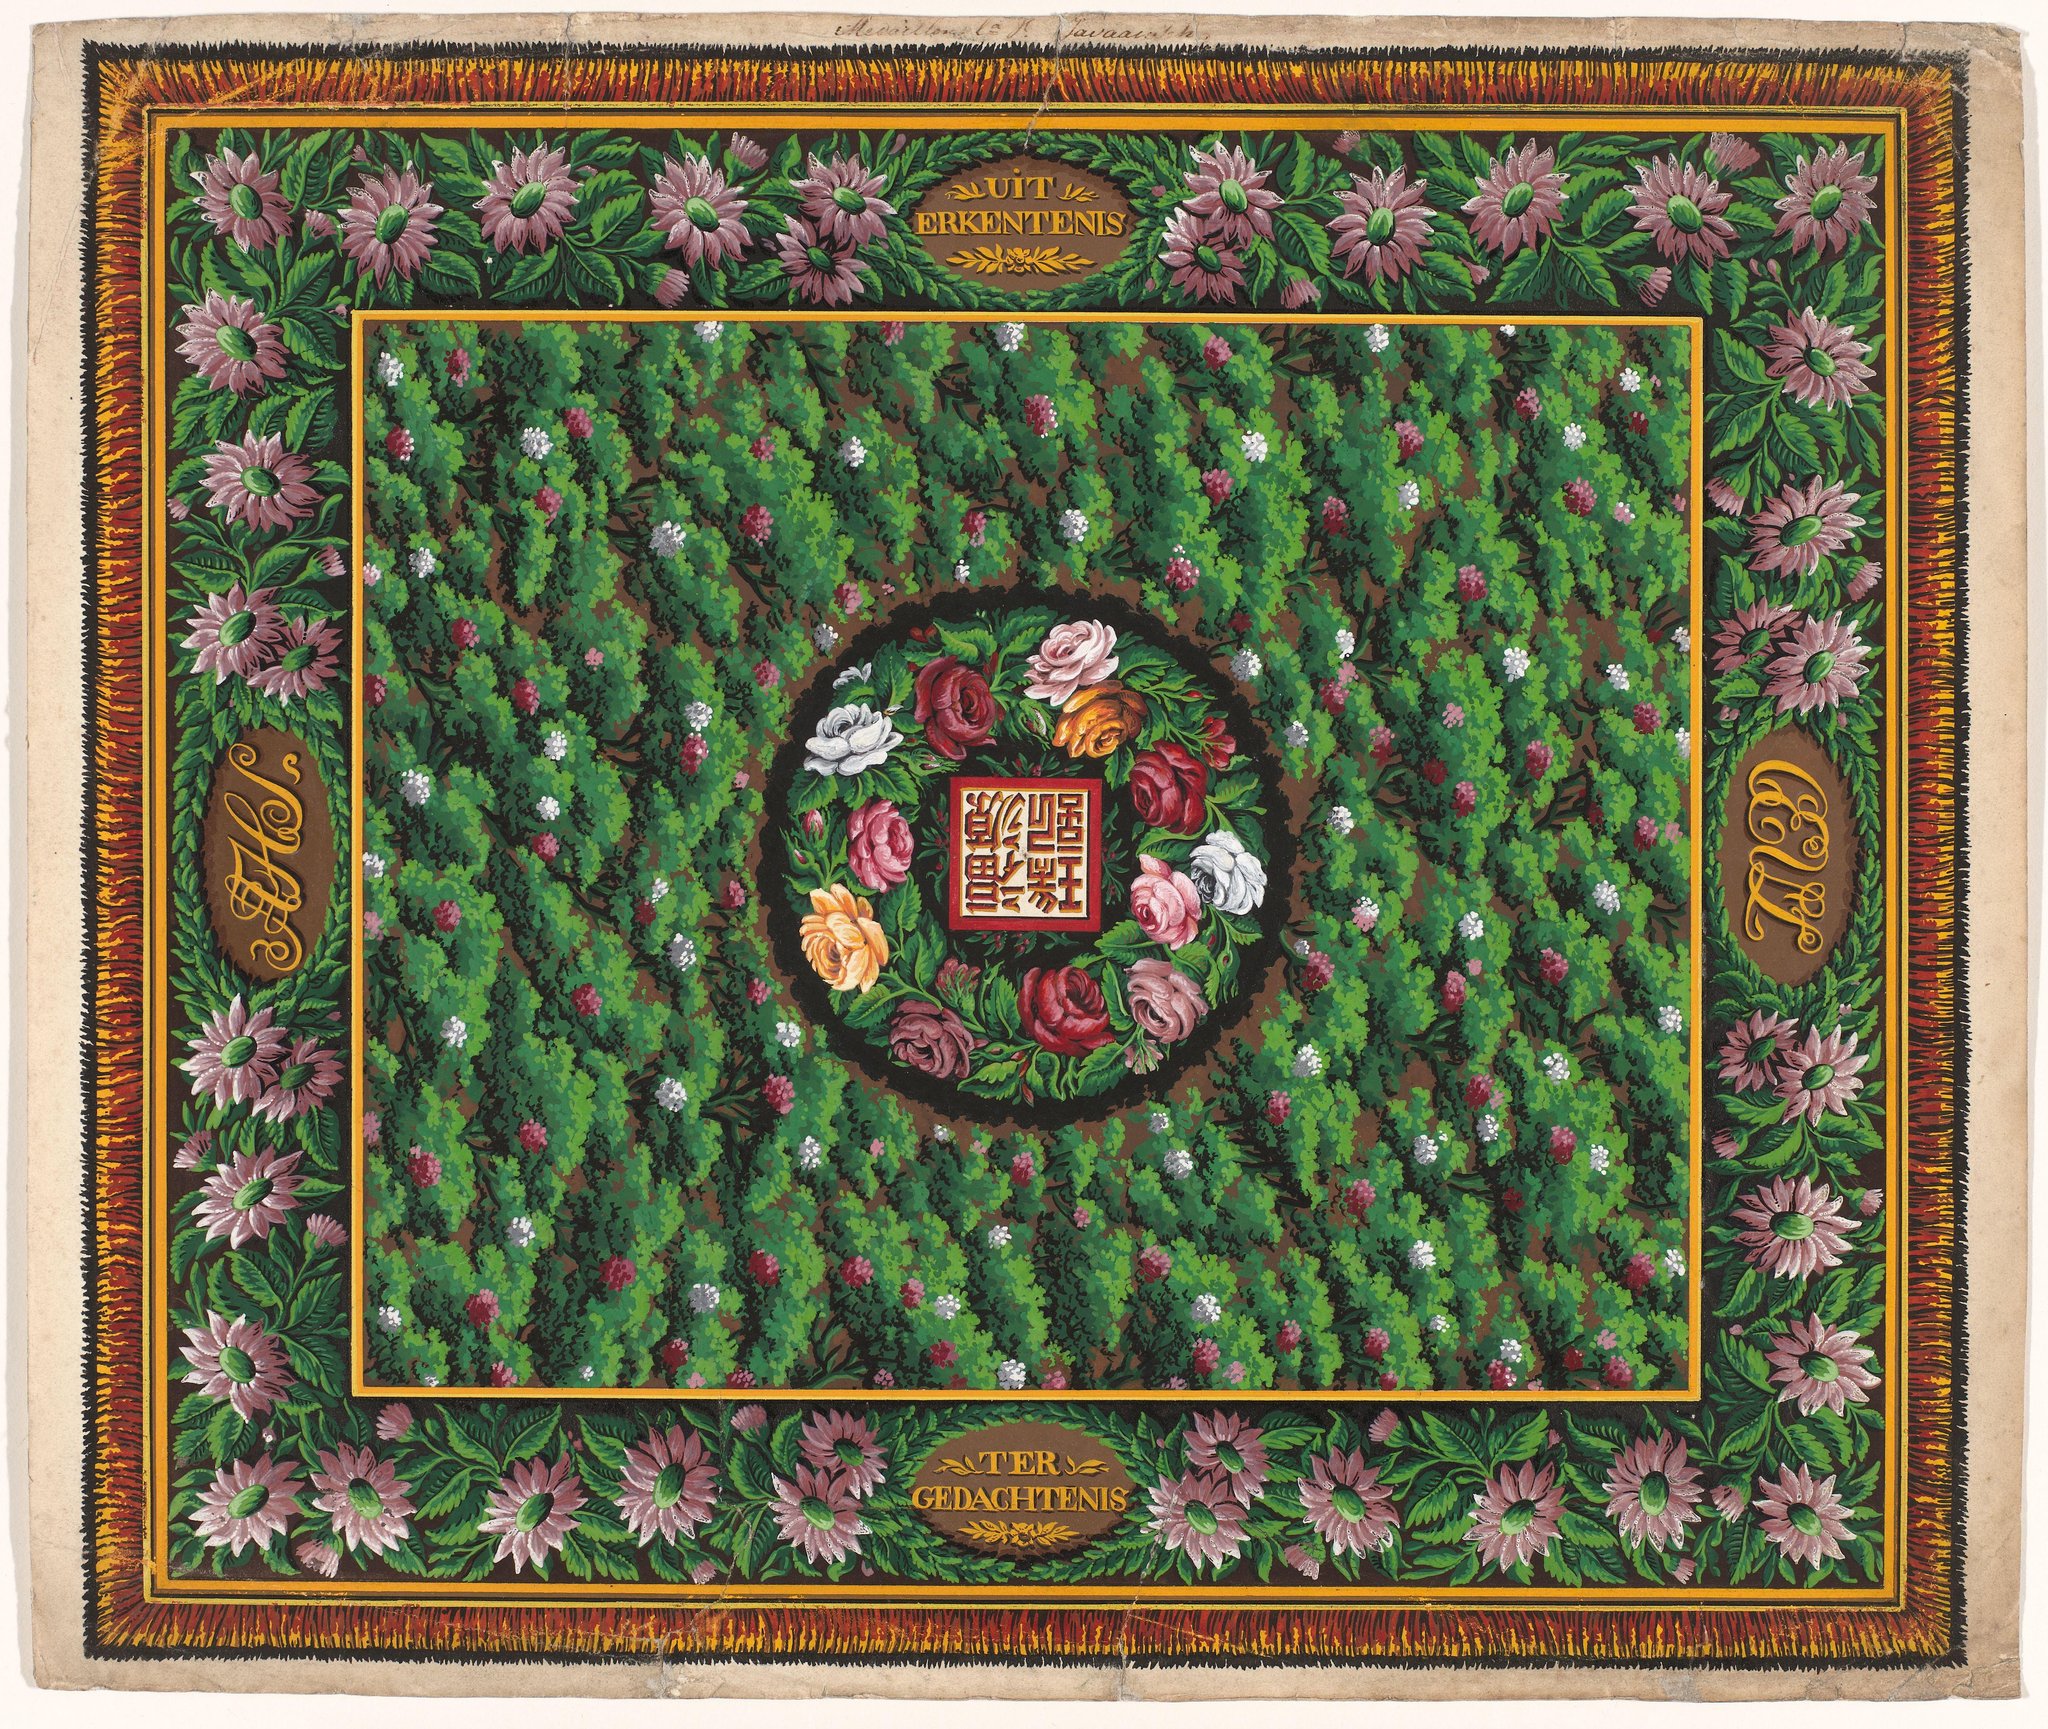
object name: design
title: Ontwerp voor een tapijt met een floraal patroon en Javaanse tekst in het centrale medaillon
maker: Anonymous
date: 1854-1864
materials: gouache, paper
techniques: brush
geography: deventer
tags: ornament derived from plant forms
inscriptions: retailer's mark: ‘JHS.’, inscription: ‘Medaillon la H. Javaansch’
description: De presentatietekeningen BK-1971-77-1 t/m 86 zijn kopieën van de originele ontwerptekeningen. Ze werden gemaakt voor vertegenwoordigers van bijvoorbeeld magazijnen, die ze aan hun klanten konden tonen. De meeste tekeningen tonen een kwart van het dessin inclusief rand, middenpartij (de zogenaamde grond of fond) en centraal medaillon. Door het gebruik van spiegels kan de illusie van het gehele tapijt worden opgeroepen. Een deel van de tekeningen heeft een alfabetische opeenvolgende letter als kenmerk, de andere groep een cijfer.Waarschijnlijk is de reeks dessins met een letter eerder samengesteld dan de genummerde tekeningen.